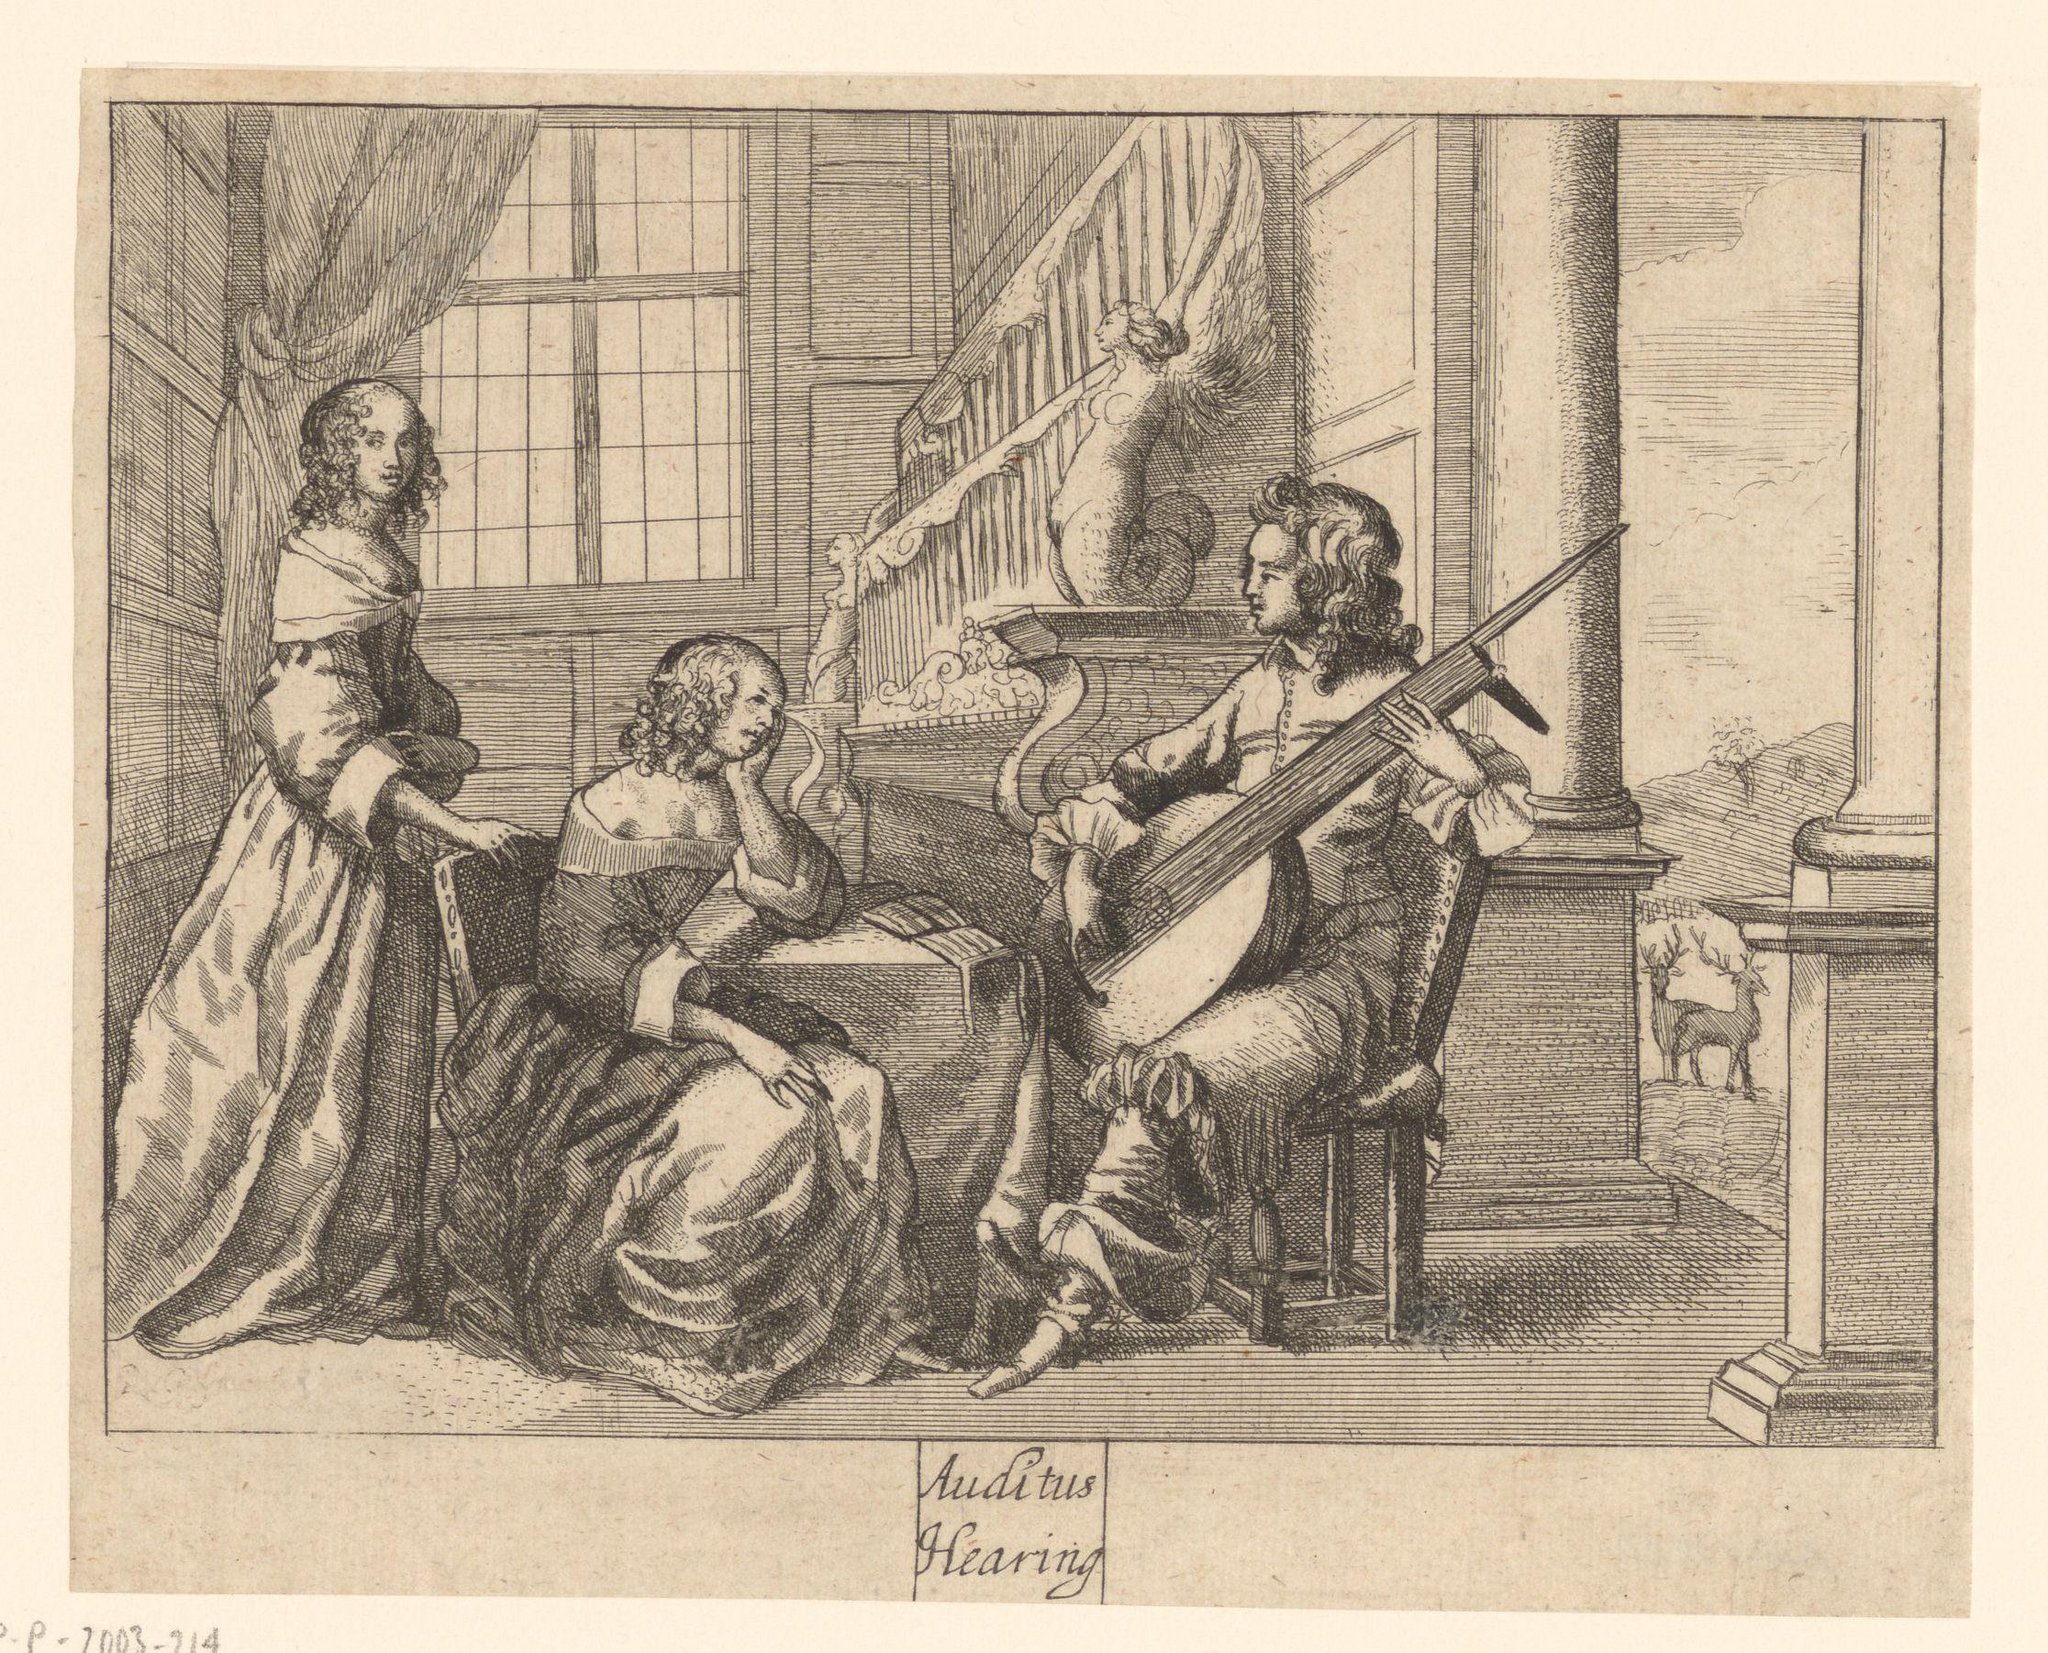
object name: print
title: Auditus / Hearing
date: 1650-1665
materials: paper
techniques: etching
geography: london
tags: hearing, listening (one of the five senses), neck-gear ~ clothing (cape collar) (+ women's clothes), organ, clothes, costume (+ women's clothes), sleeves: cuffs (+ women's clothes), dress, gown (+ women's clothes), clothes, costume (+ men's clothes), lute, and special forms of lute, e.g.: theorbo, one person playing an instrument, trousers, breeches, etc. (breeches) (+ men's clothes), boots (+ men's clothes)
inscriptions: collector's mark: Lugt 2228, collector's mark: Lugt 2760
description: Deze prent maakt deel uit van een serie van vijf prenten, compleet in het bezit van het Rijksmuseum.